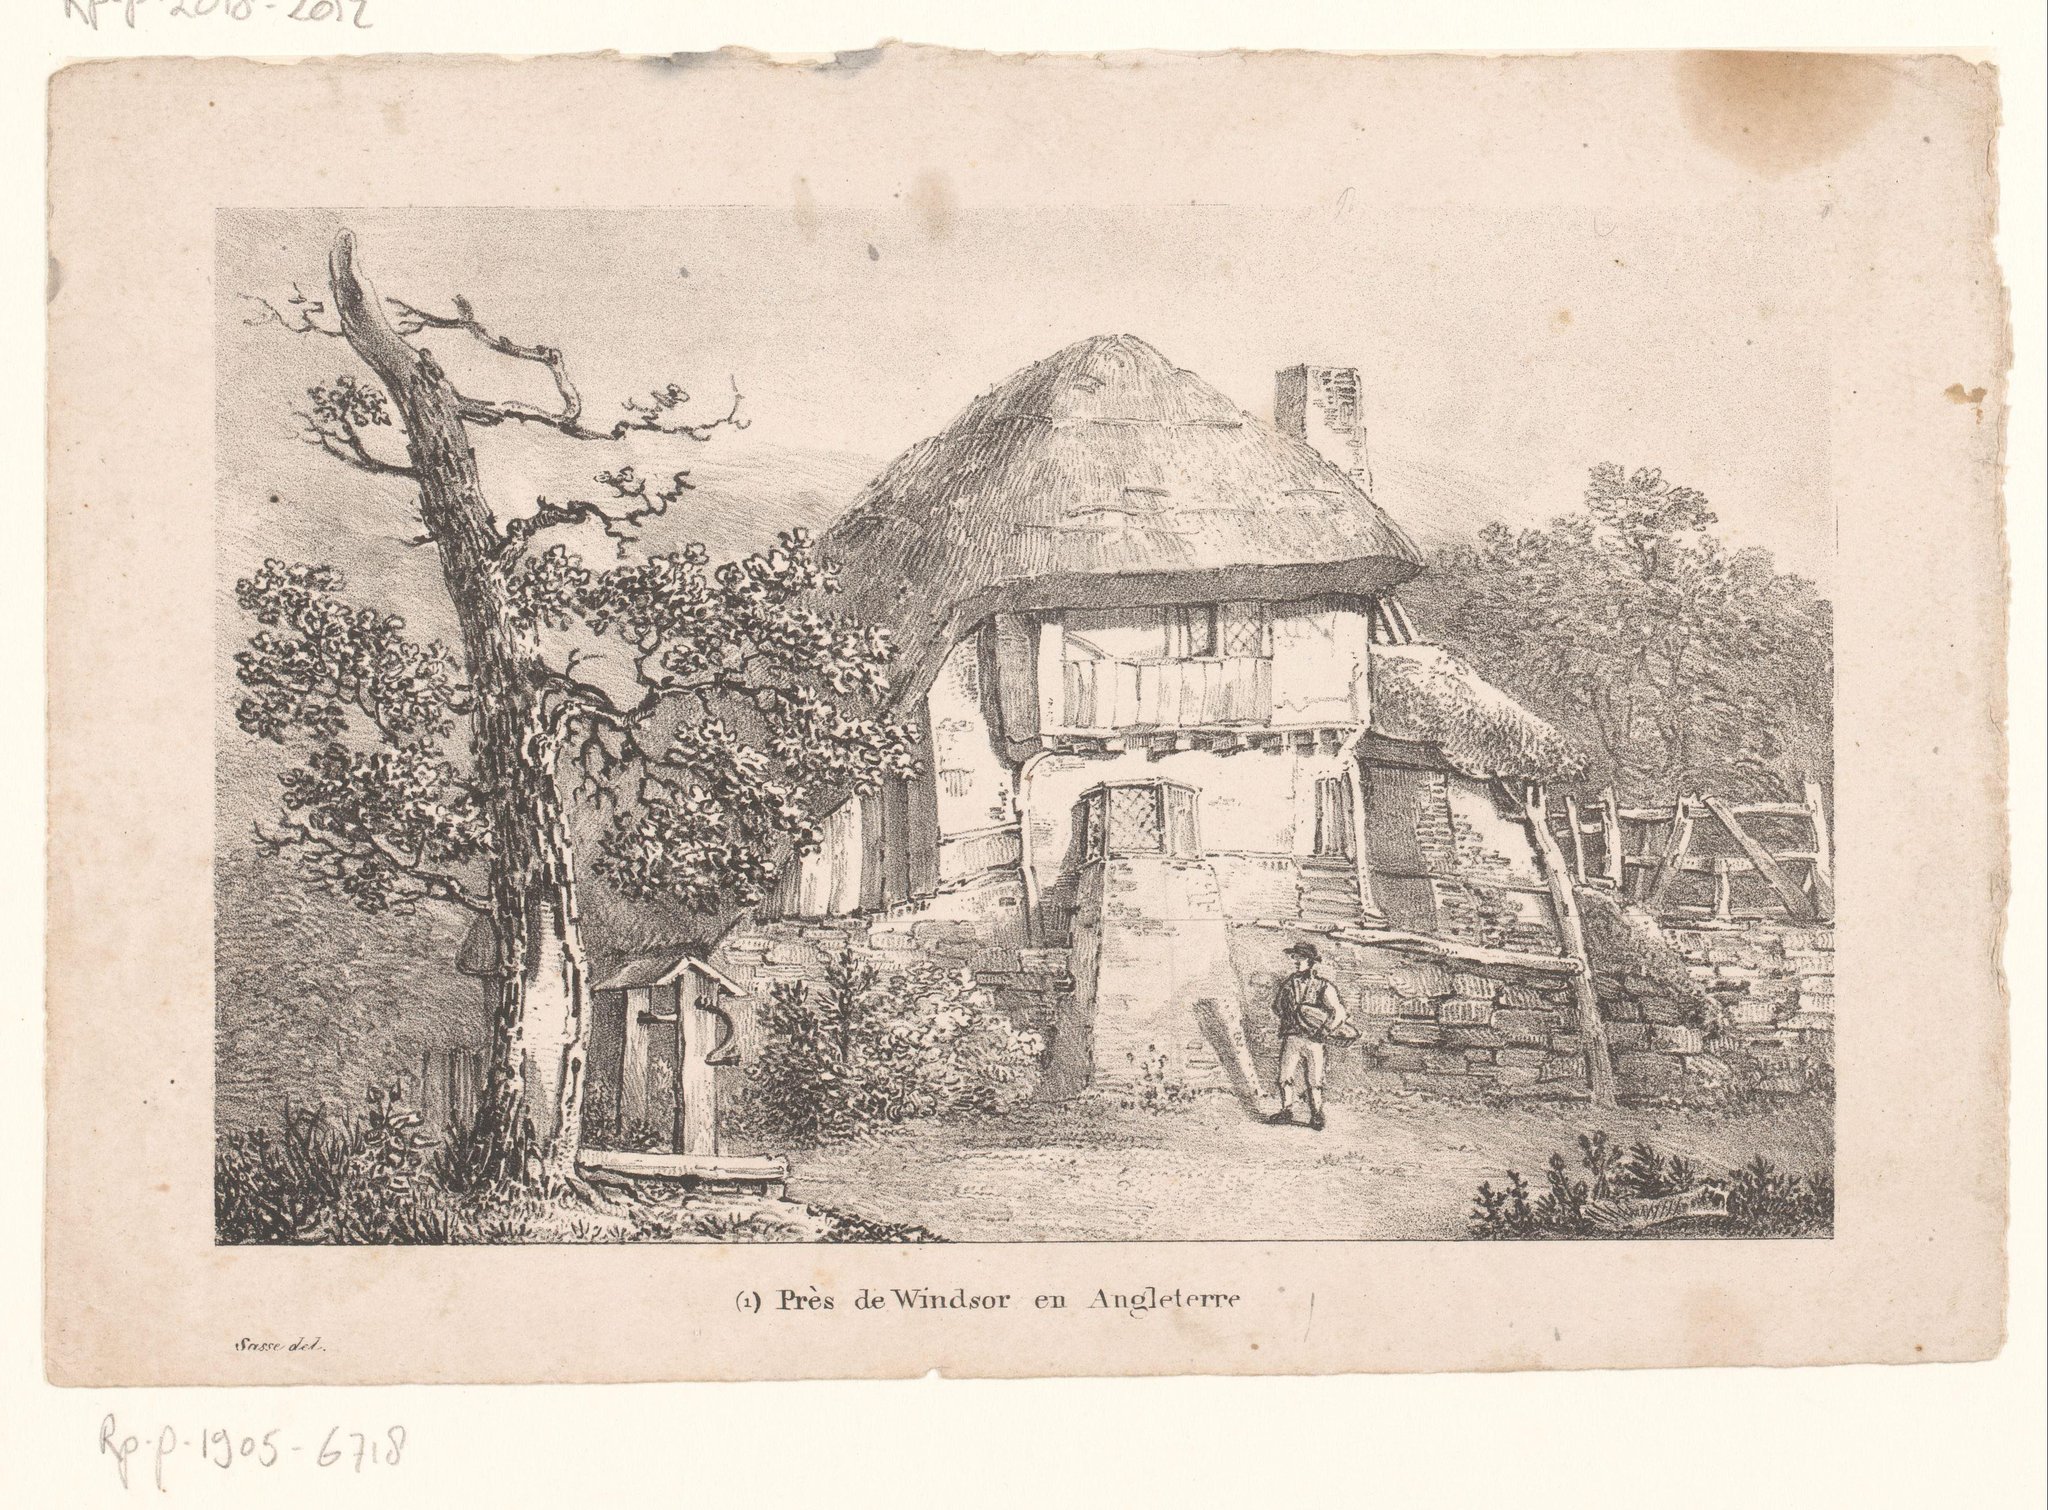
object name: print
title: Gezicht op een boerderij, in de buurt van Windsor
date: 1825-1849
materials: paper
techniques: lithograph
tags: farm (building)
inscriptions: collector's mark: Lugt 2228